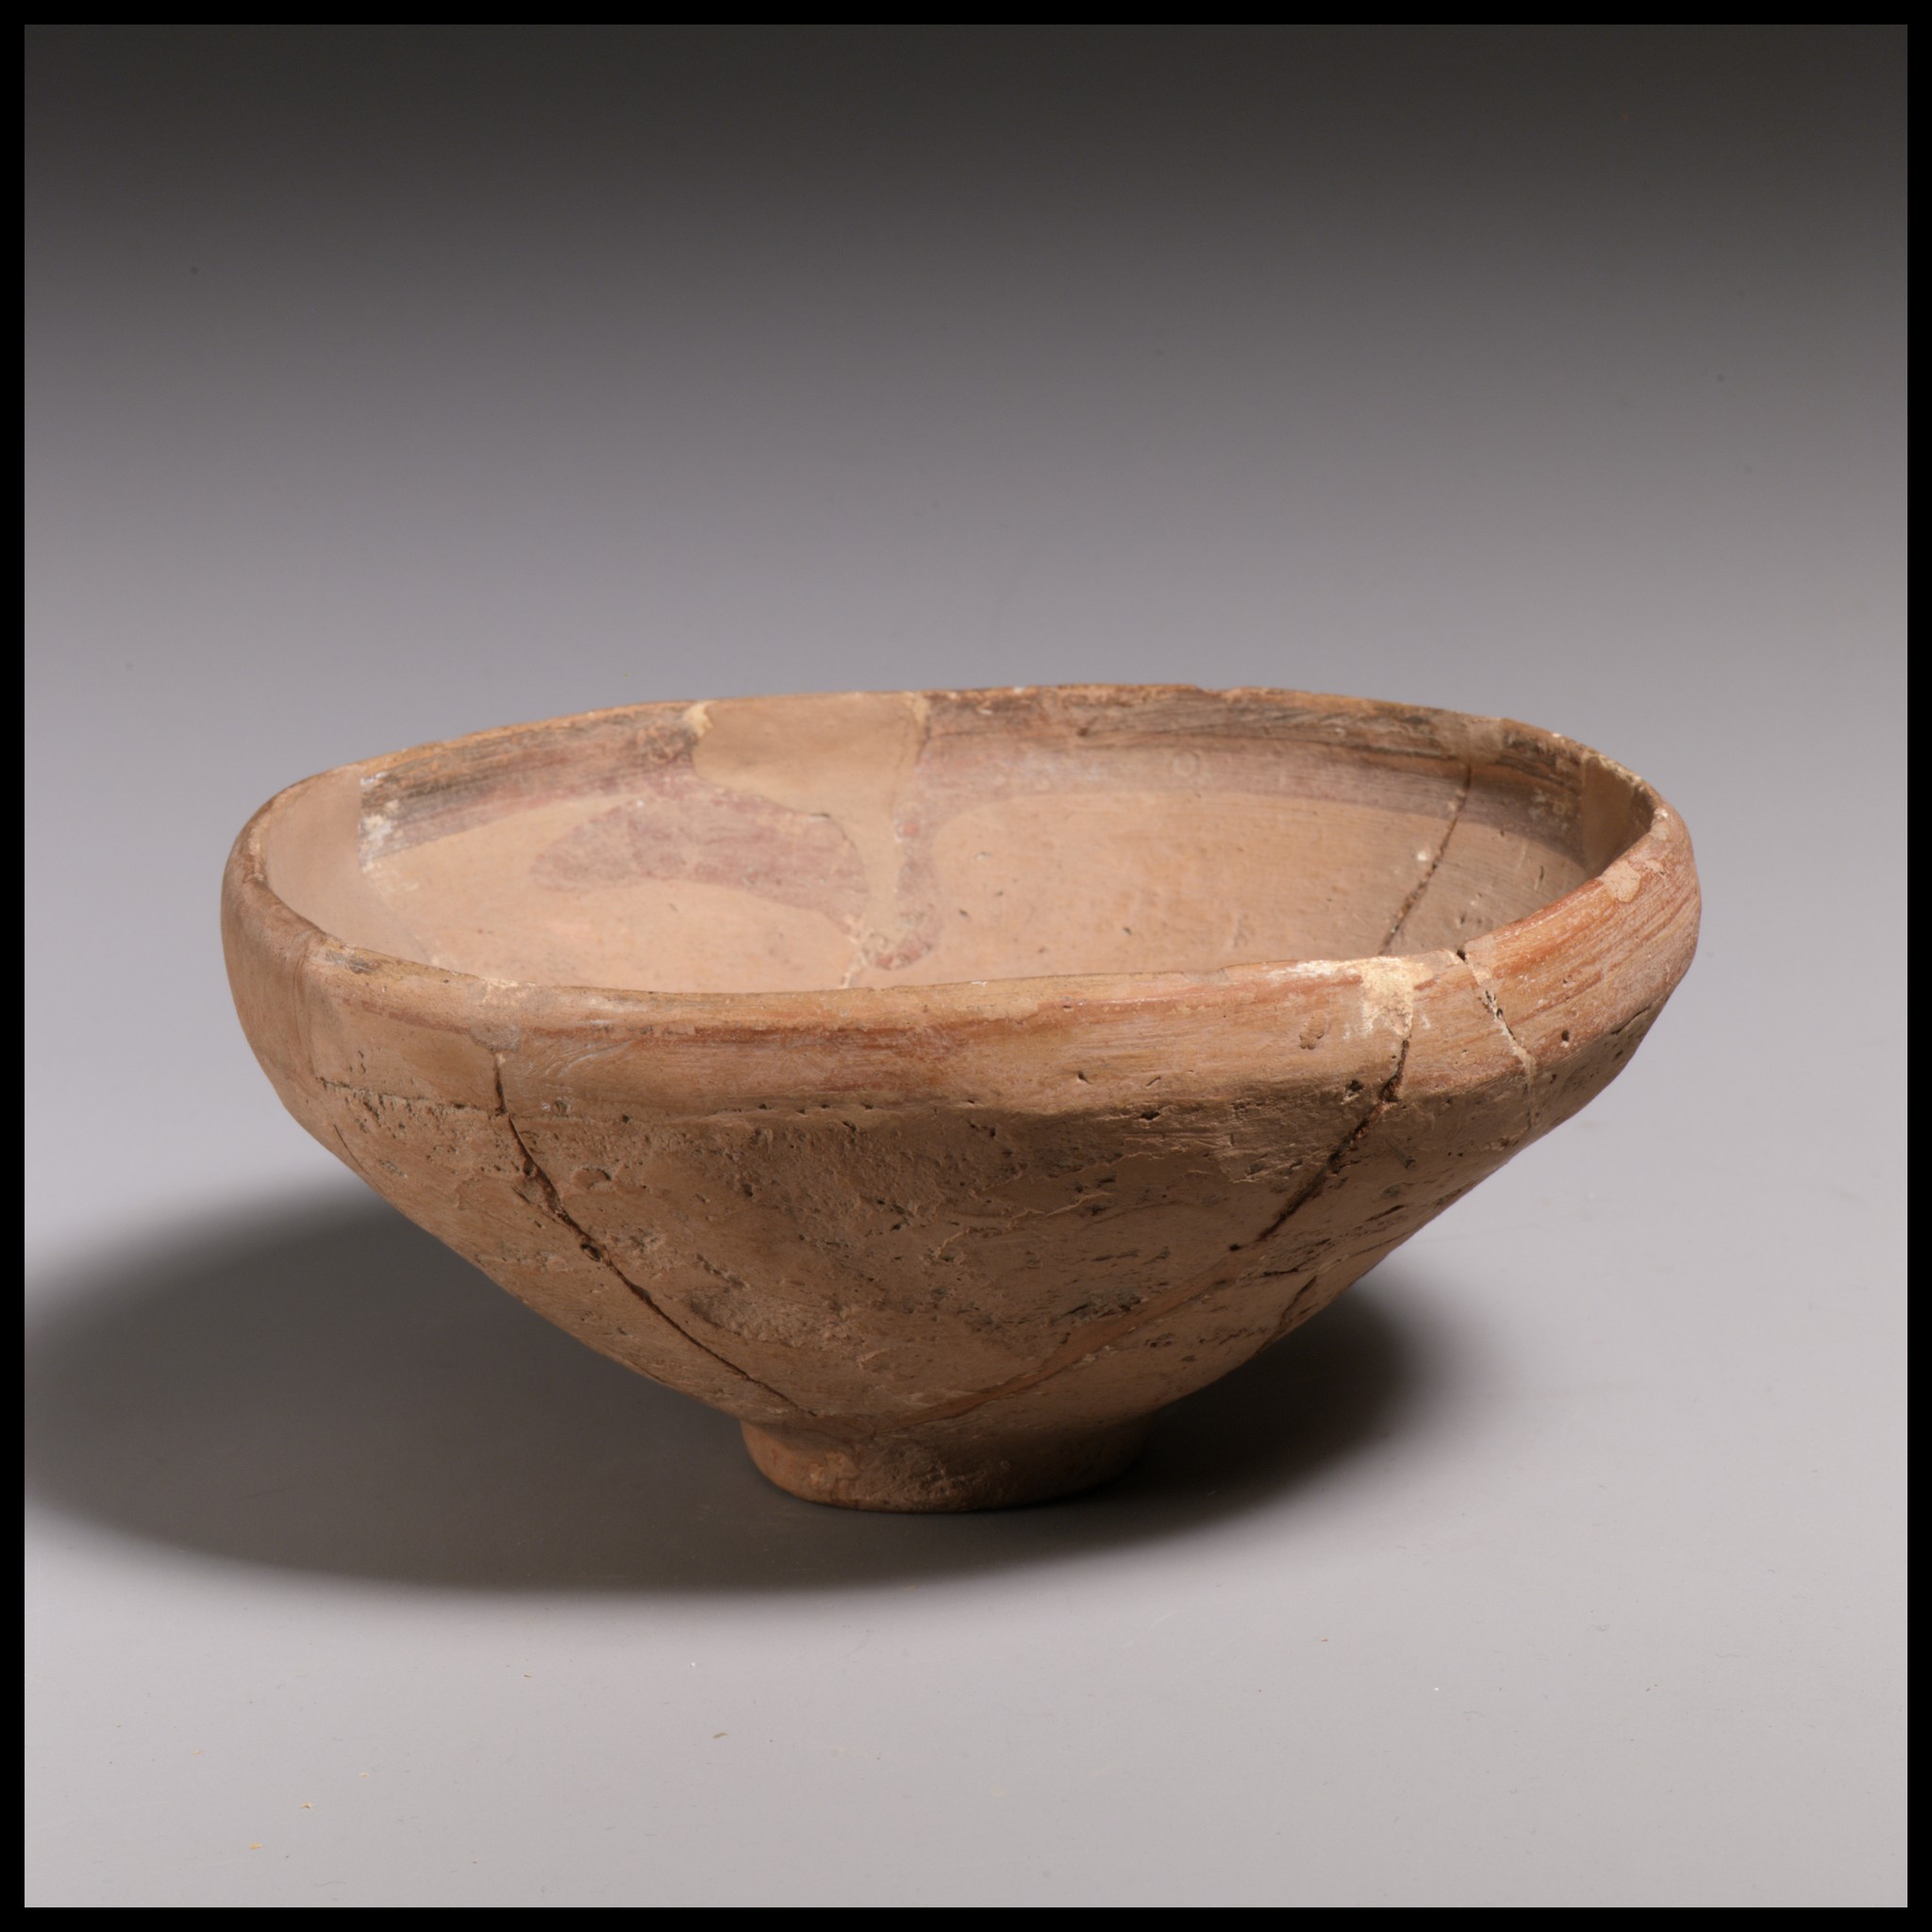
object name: bowl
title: Terracotta bowl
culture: helladic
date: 2650-2150 BCE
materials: terracotta